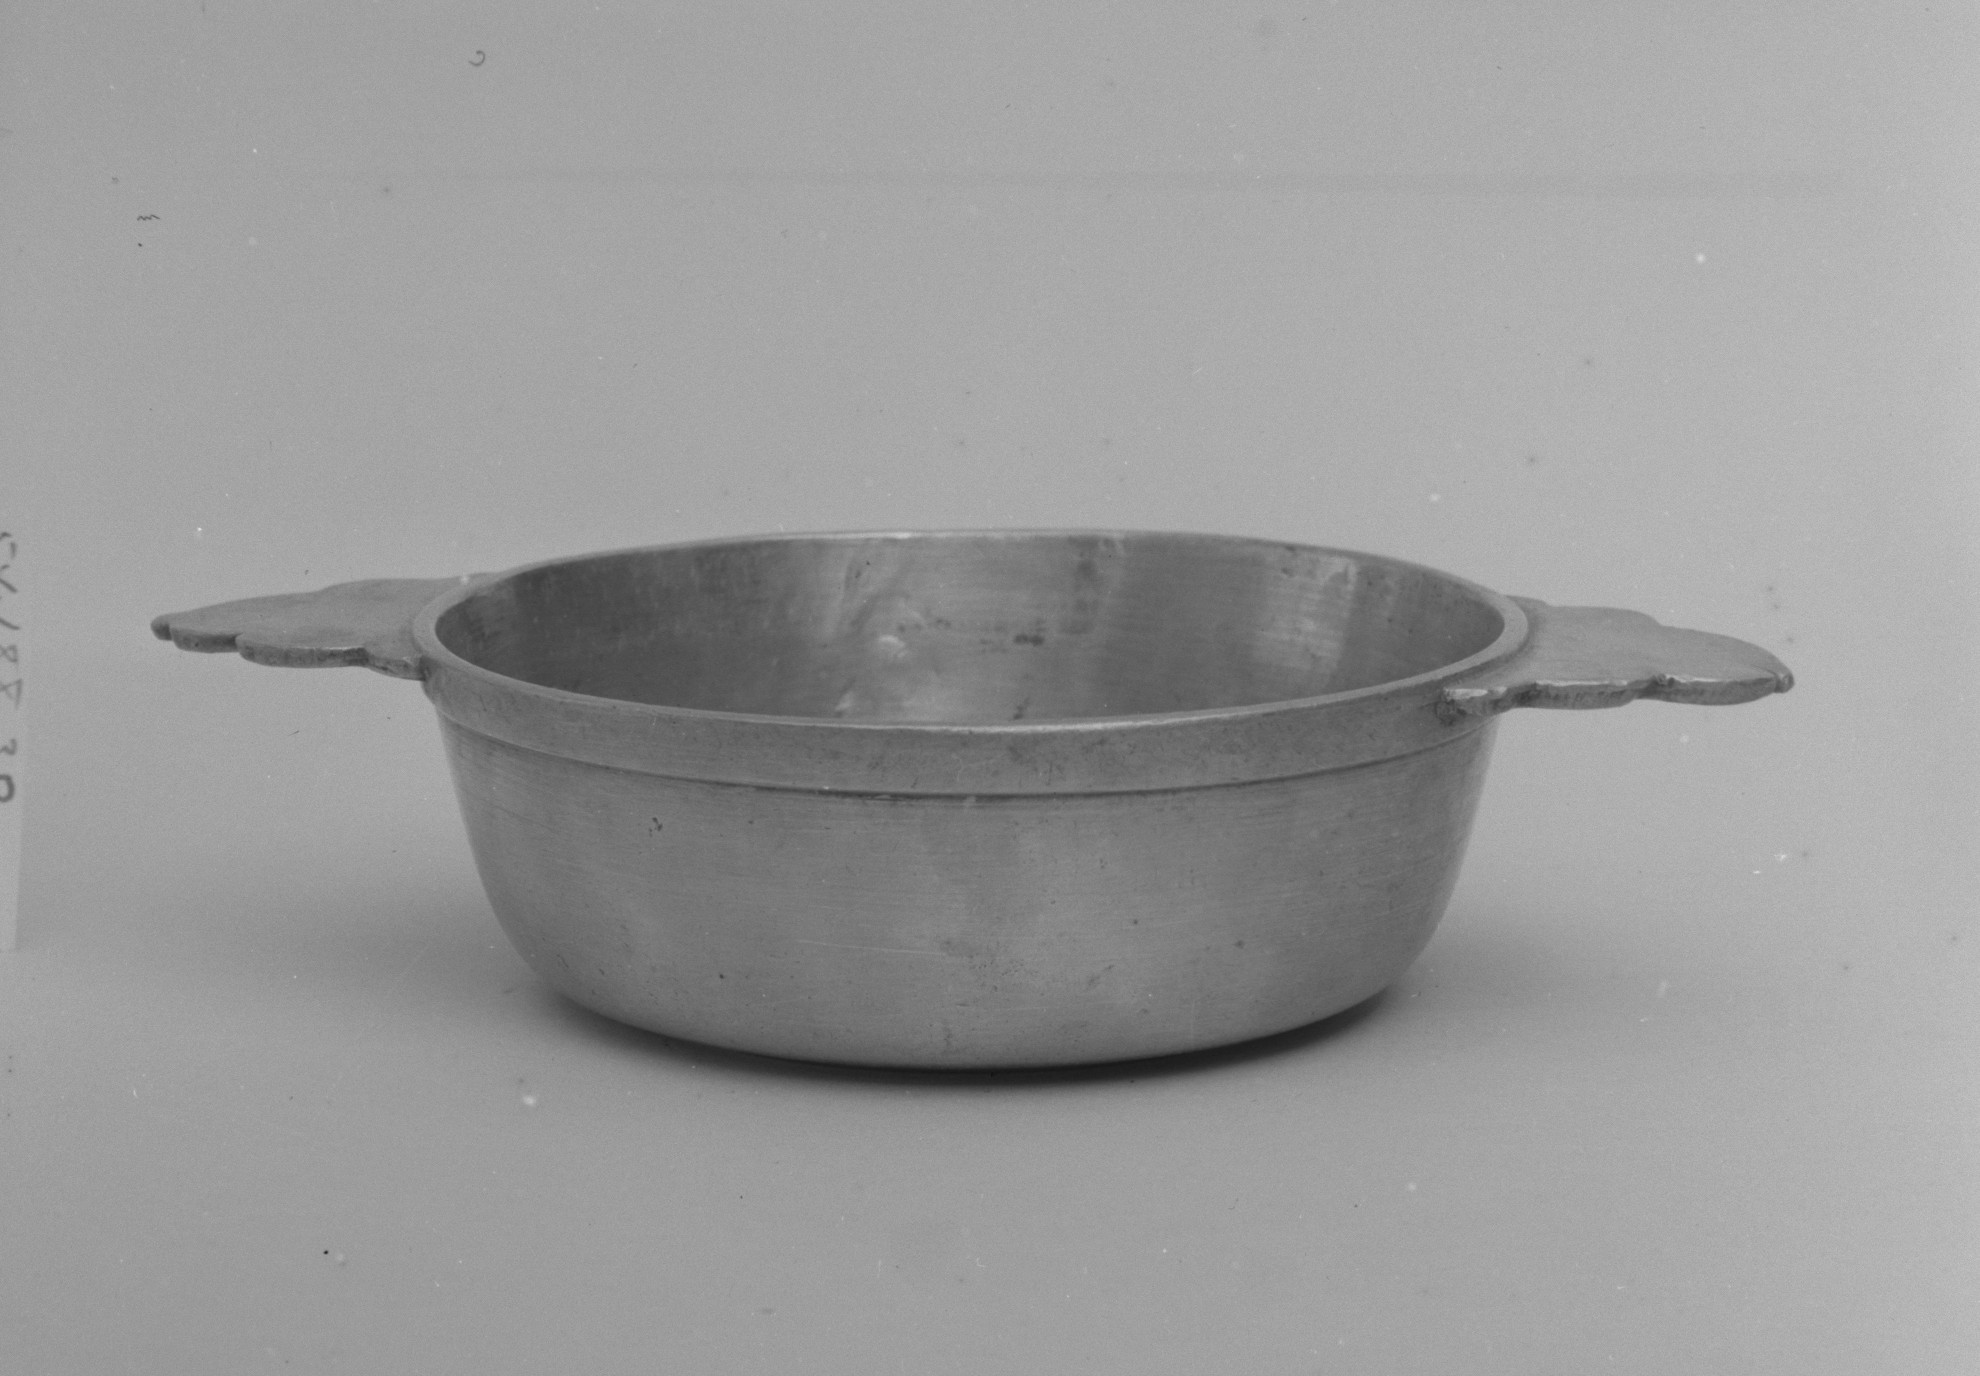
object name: bowl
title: Bowl (from a set of four)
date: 1701-1800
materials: pewter